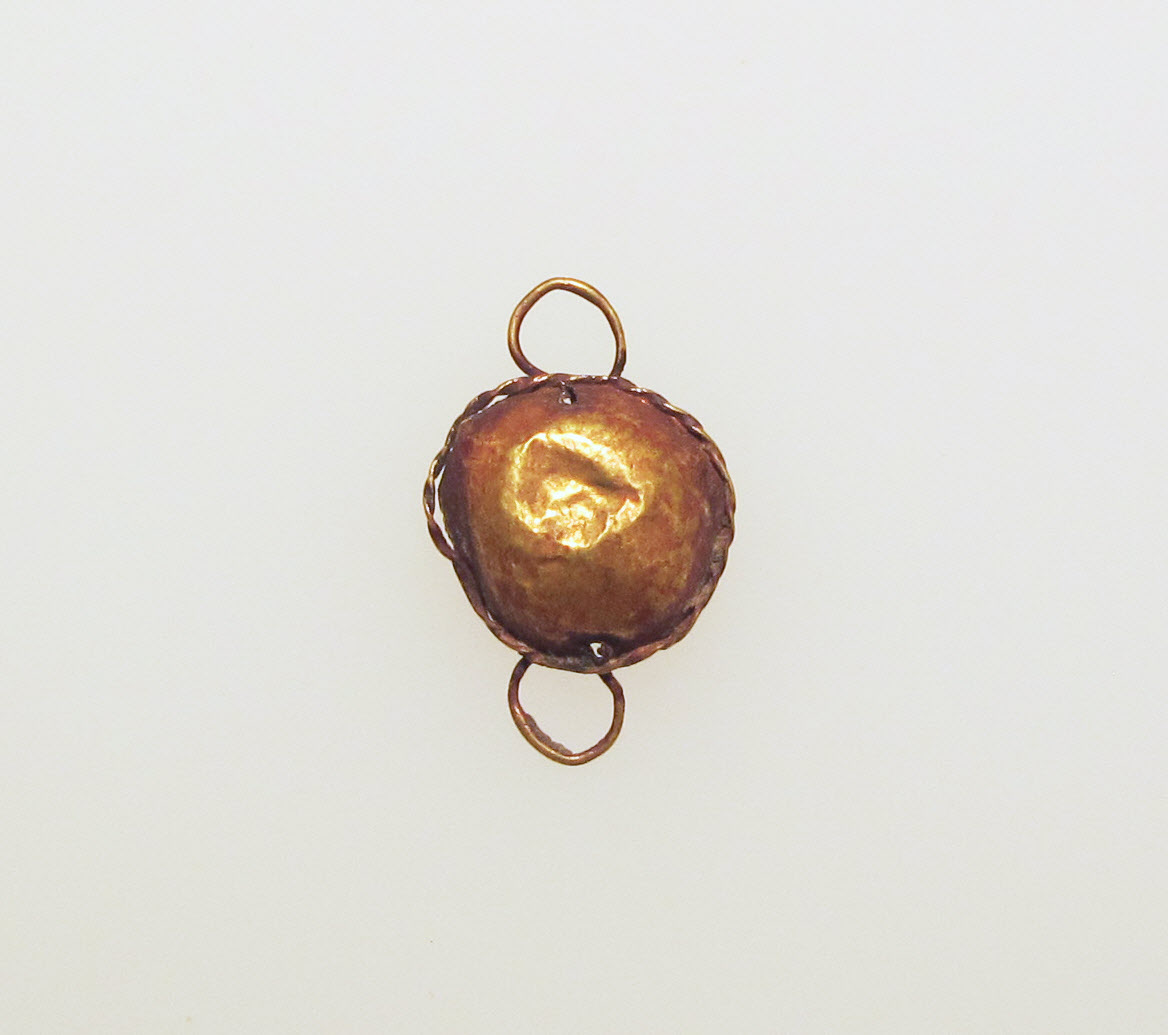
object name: roundel, bos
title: Roundel, boss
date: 7000 BCE-330 CE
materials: gold